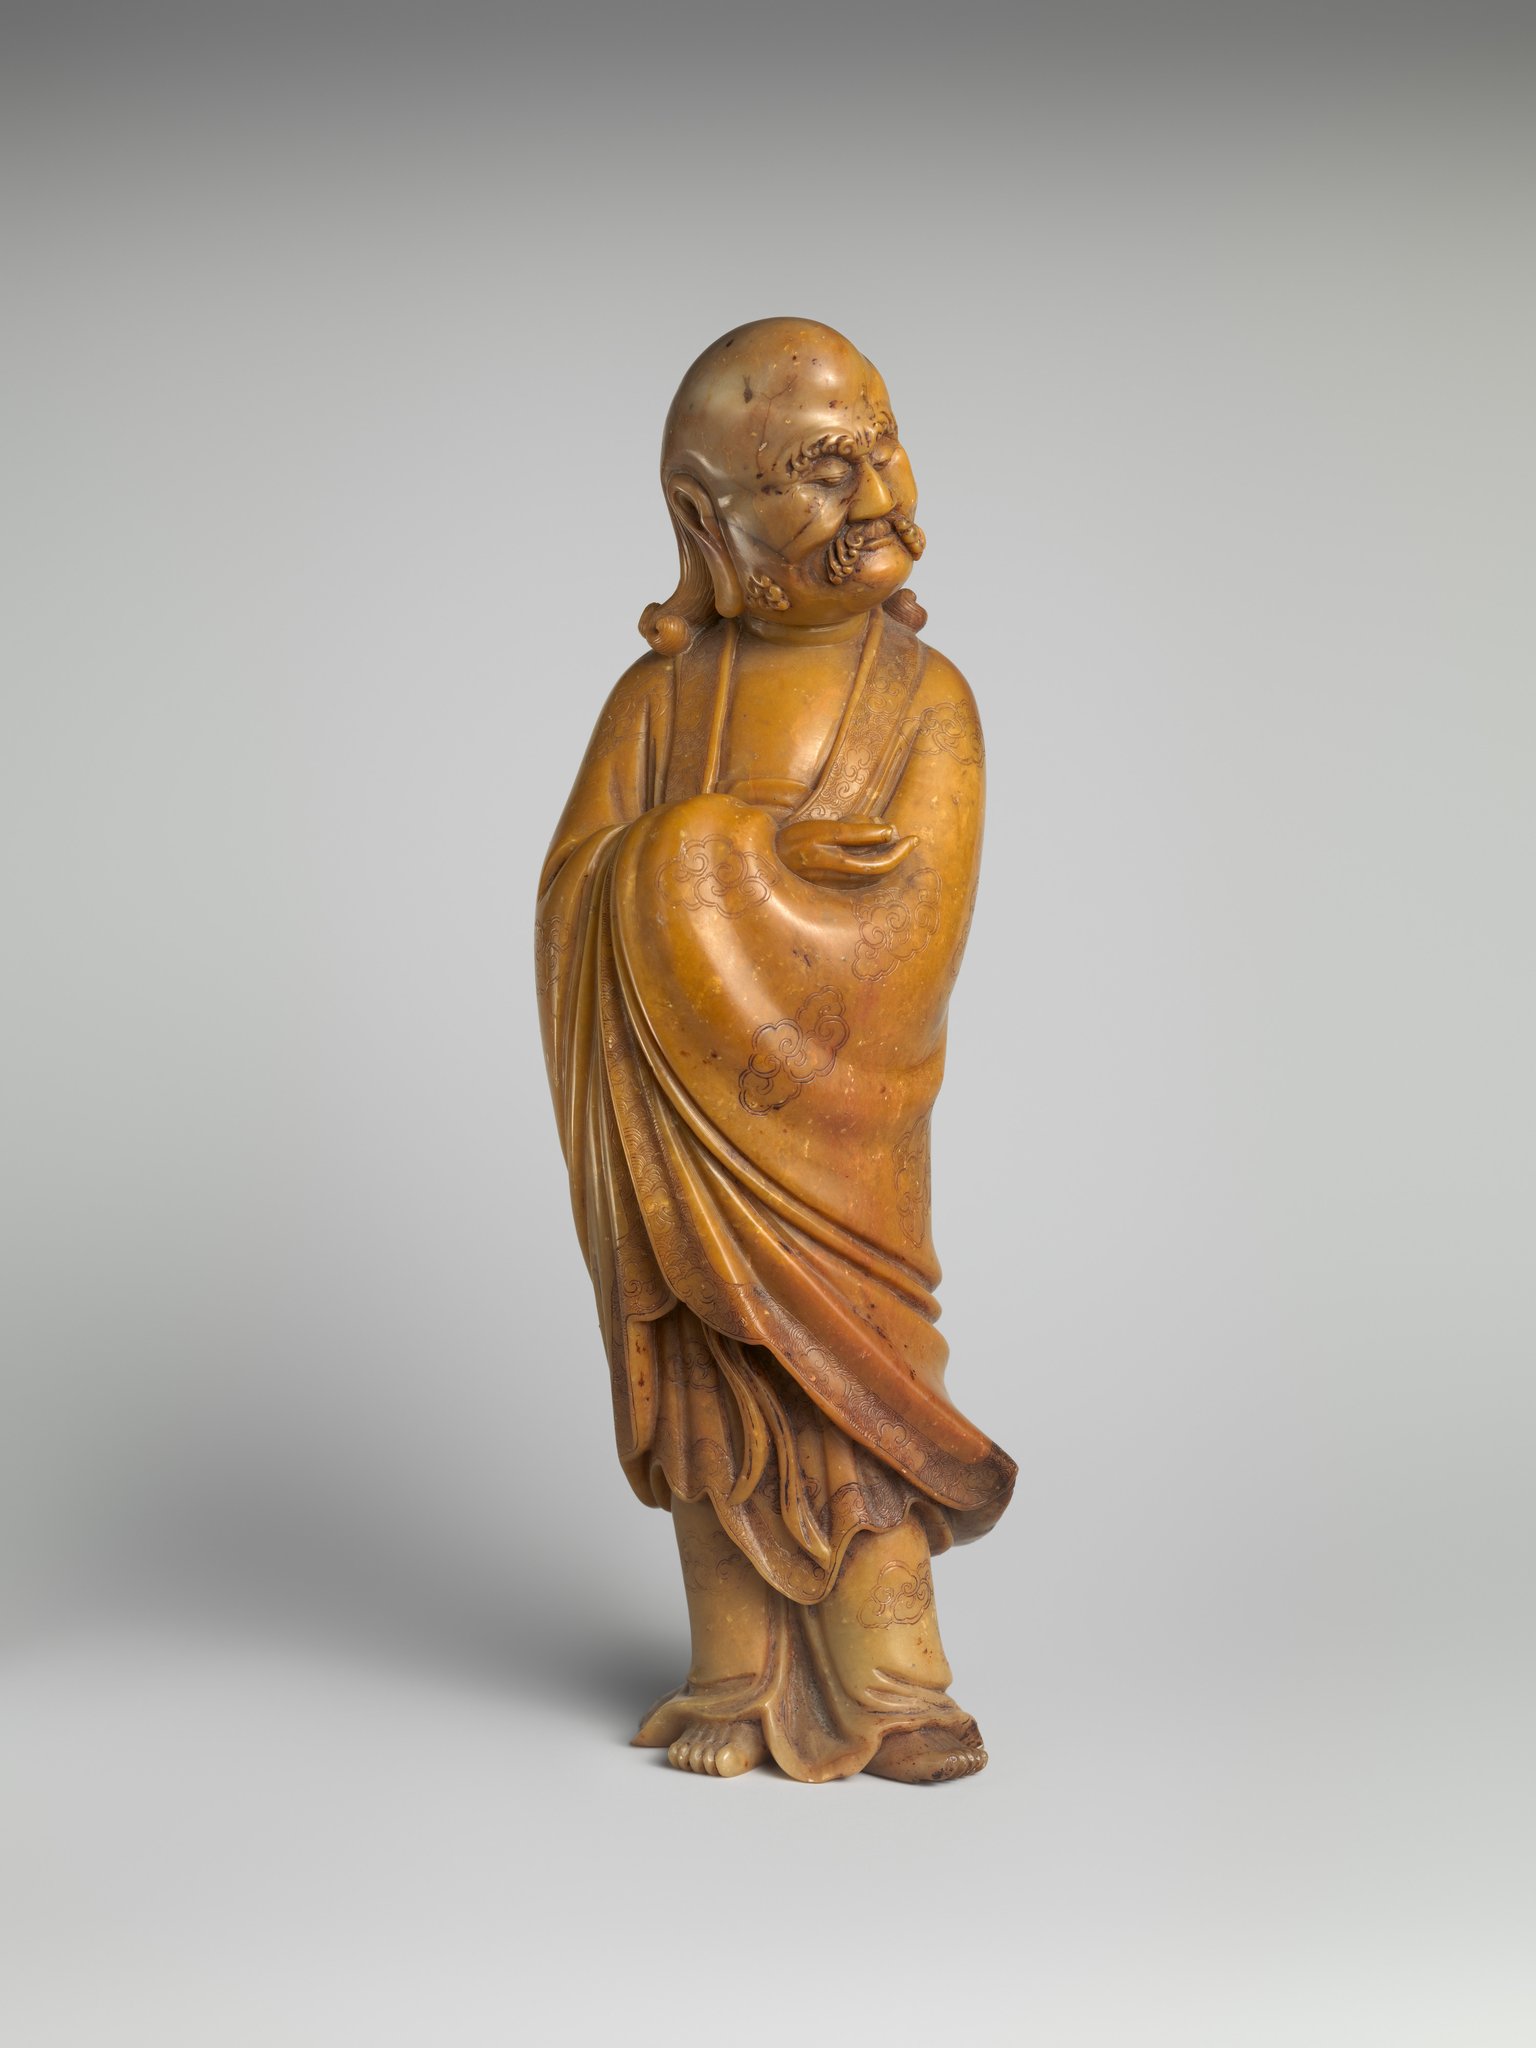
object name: figure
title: Bodhidharma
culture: chinese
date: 1801-1900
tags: men,monks